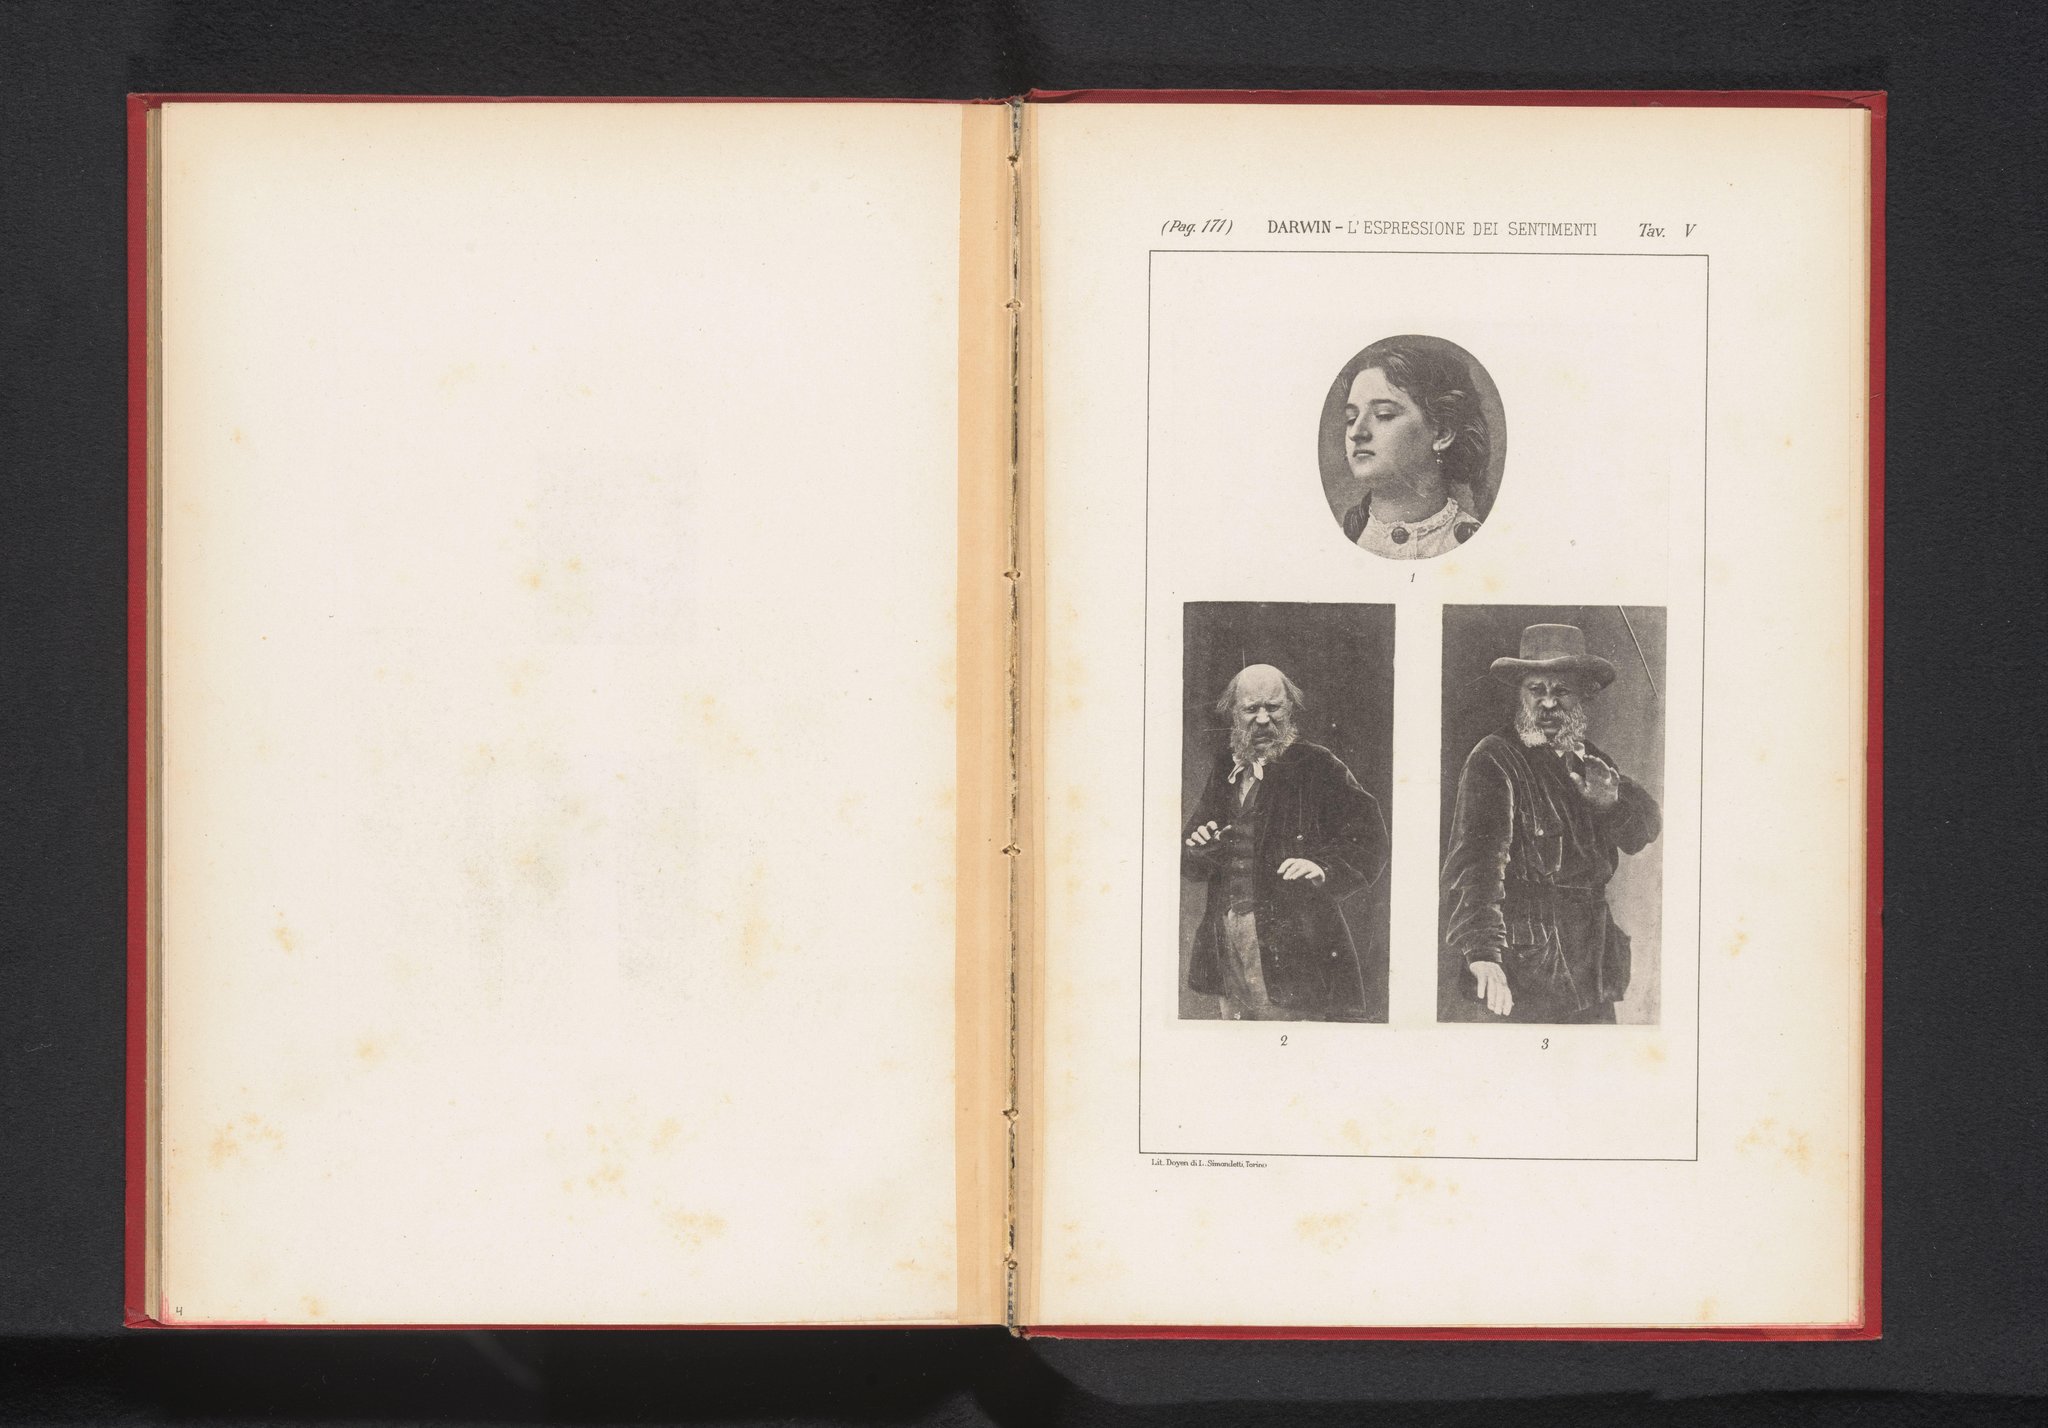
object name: page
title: Drie portretten van onbekende mannen en vrouwen die minachting tonen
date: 1880-1890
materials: paper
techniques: photograph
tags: passions, emotions, affections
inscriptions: number: ‘Tav. V 1 2 3 (Pag. 171)’